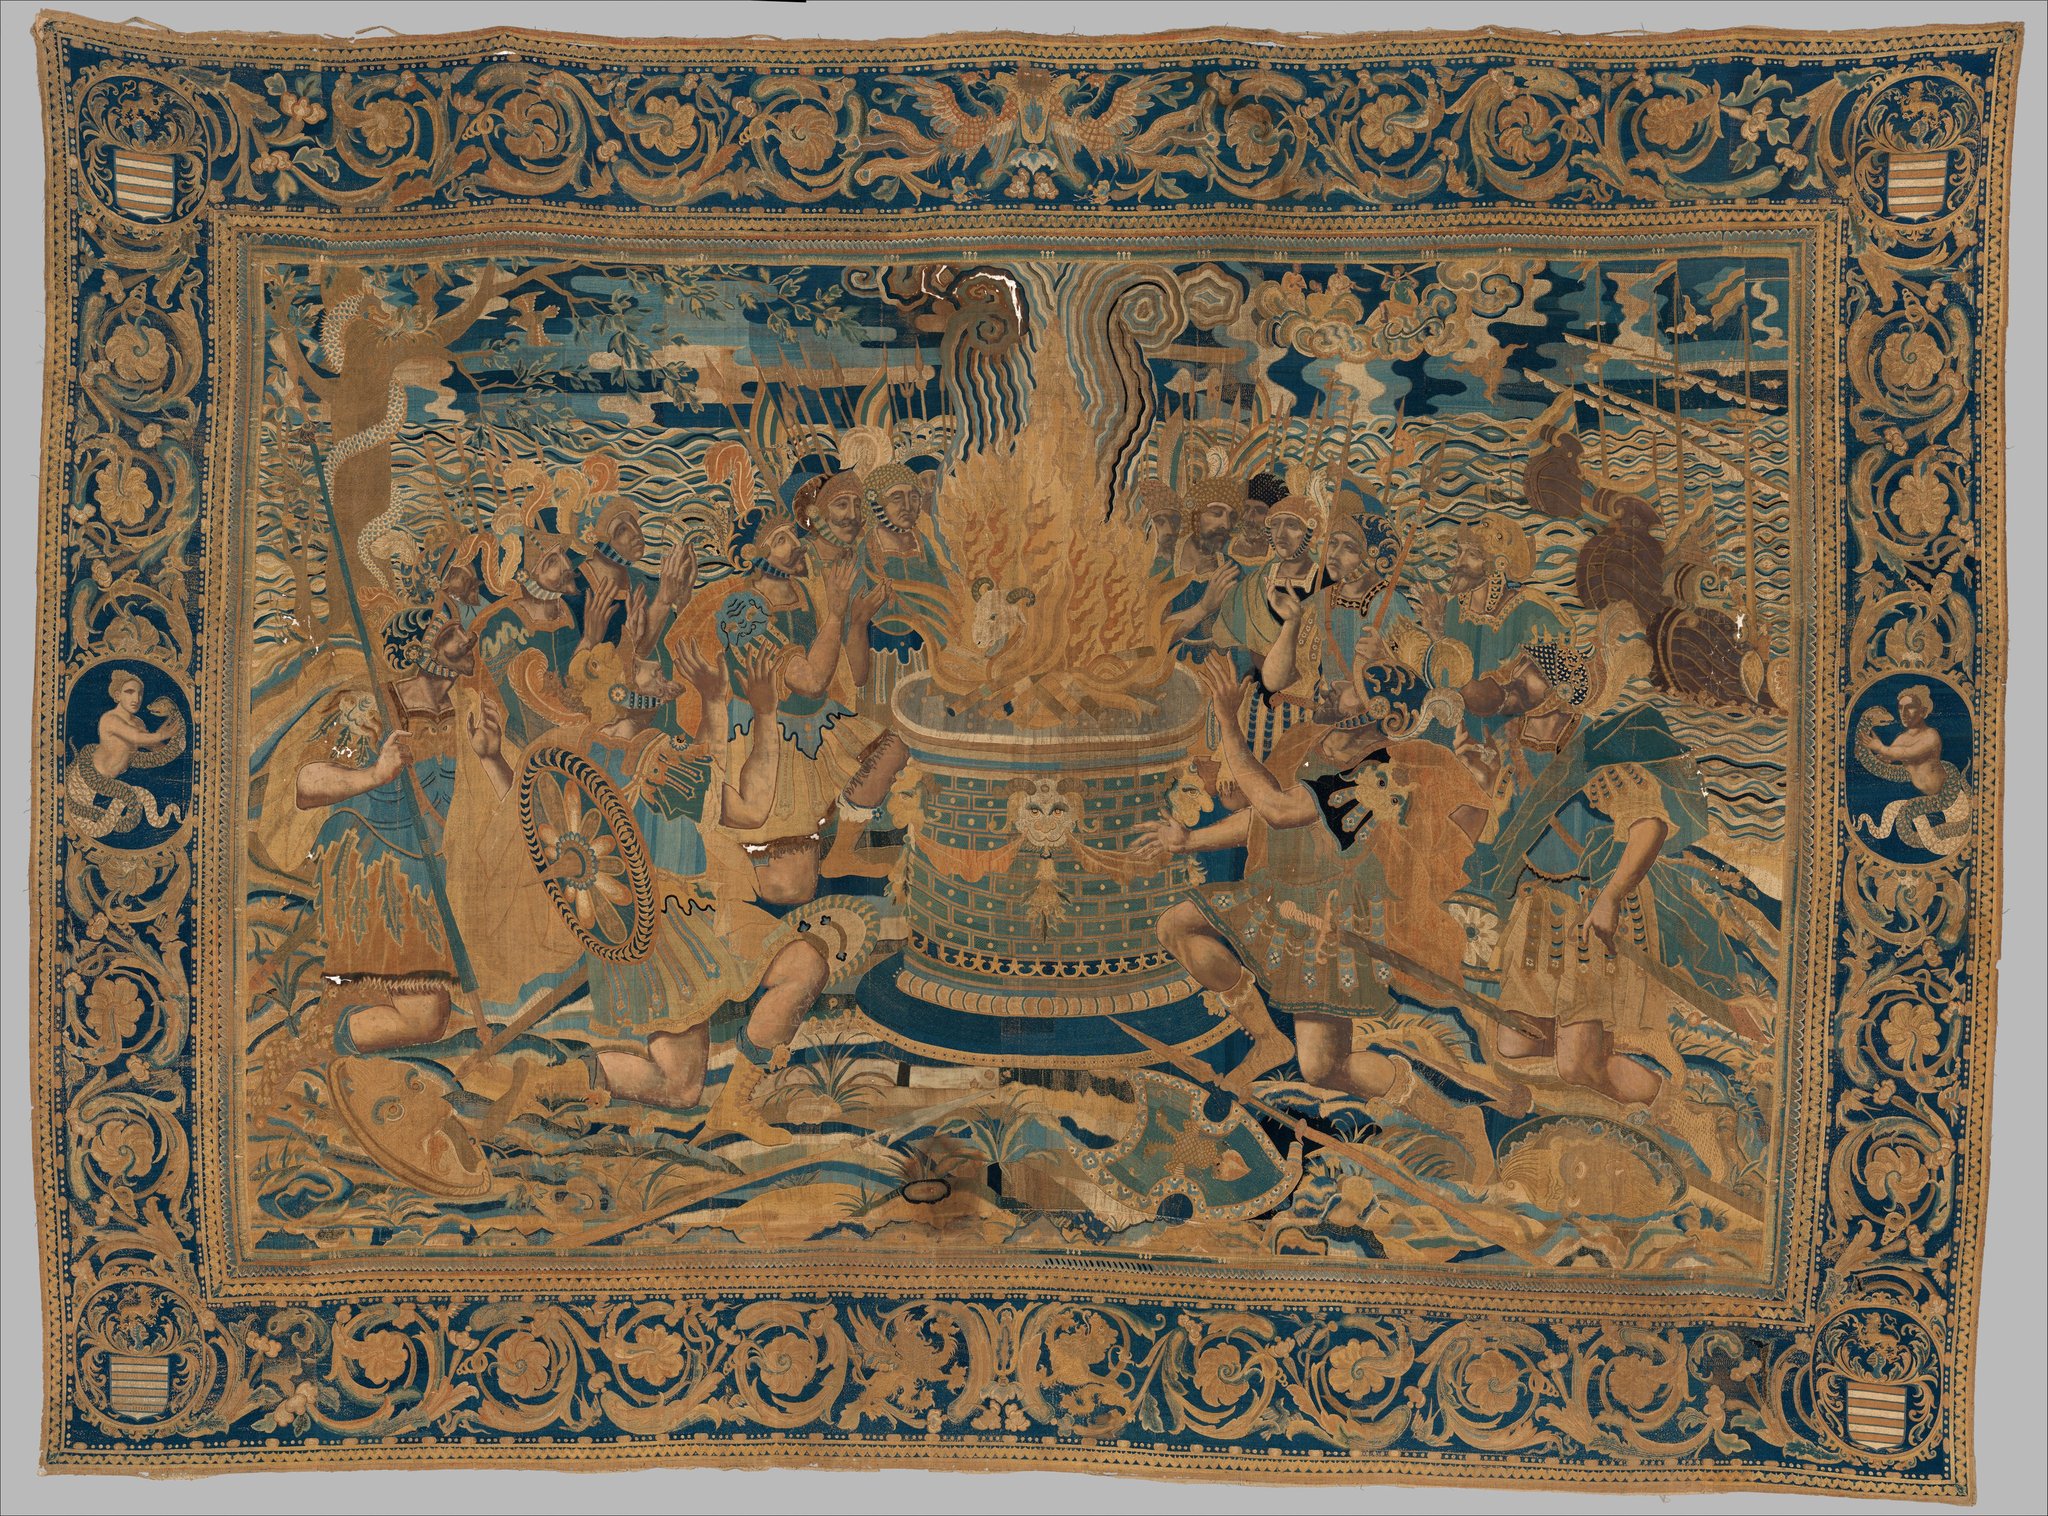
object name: hanging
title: The Prophecy of Calchas from a set of The Story of Troy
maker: bernard salomon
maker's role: artist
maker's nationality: french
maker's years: 1508-1561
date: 1625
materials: cotton, gilt, paper, pigment, silk, thread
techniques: embroidery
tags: soldiers,men,fire